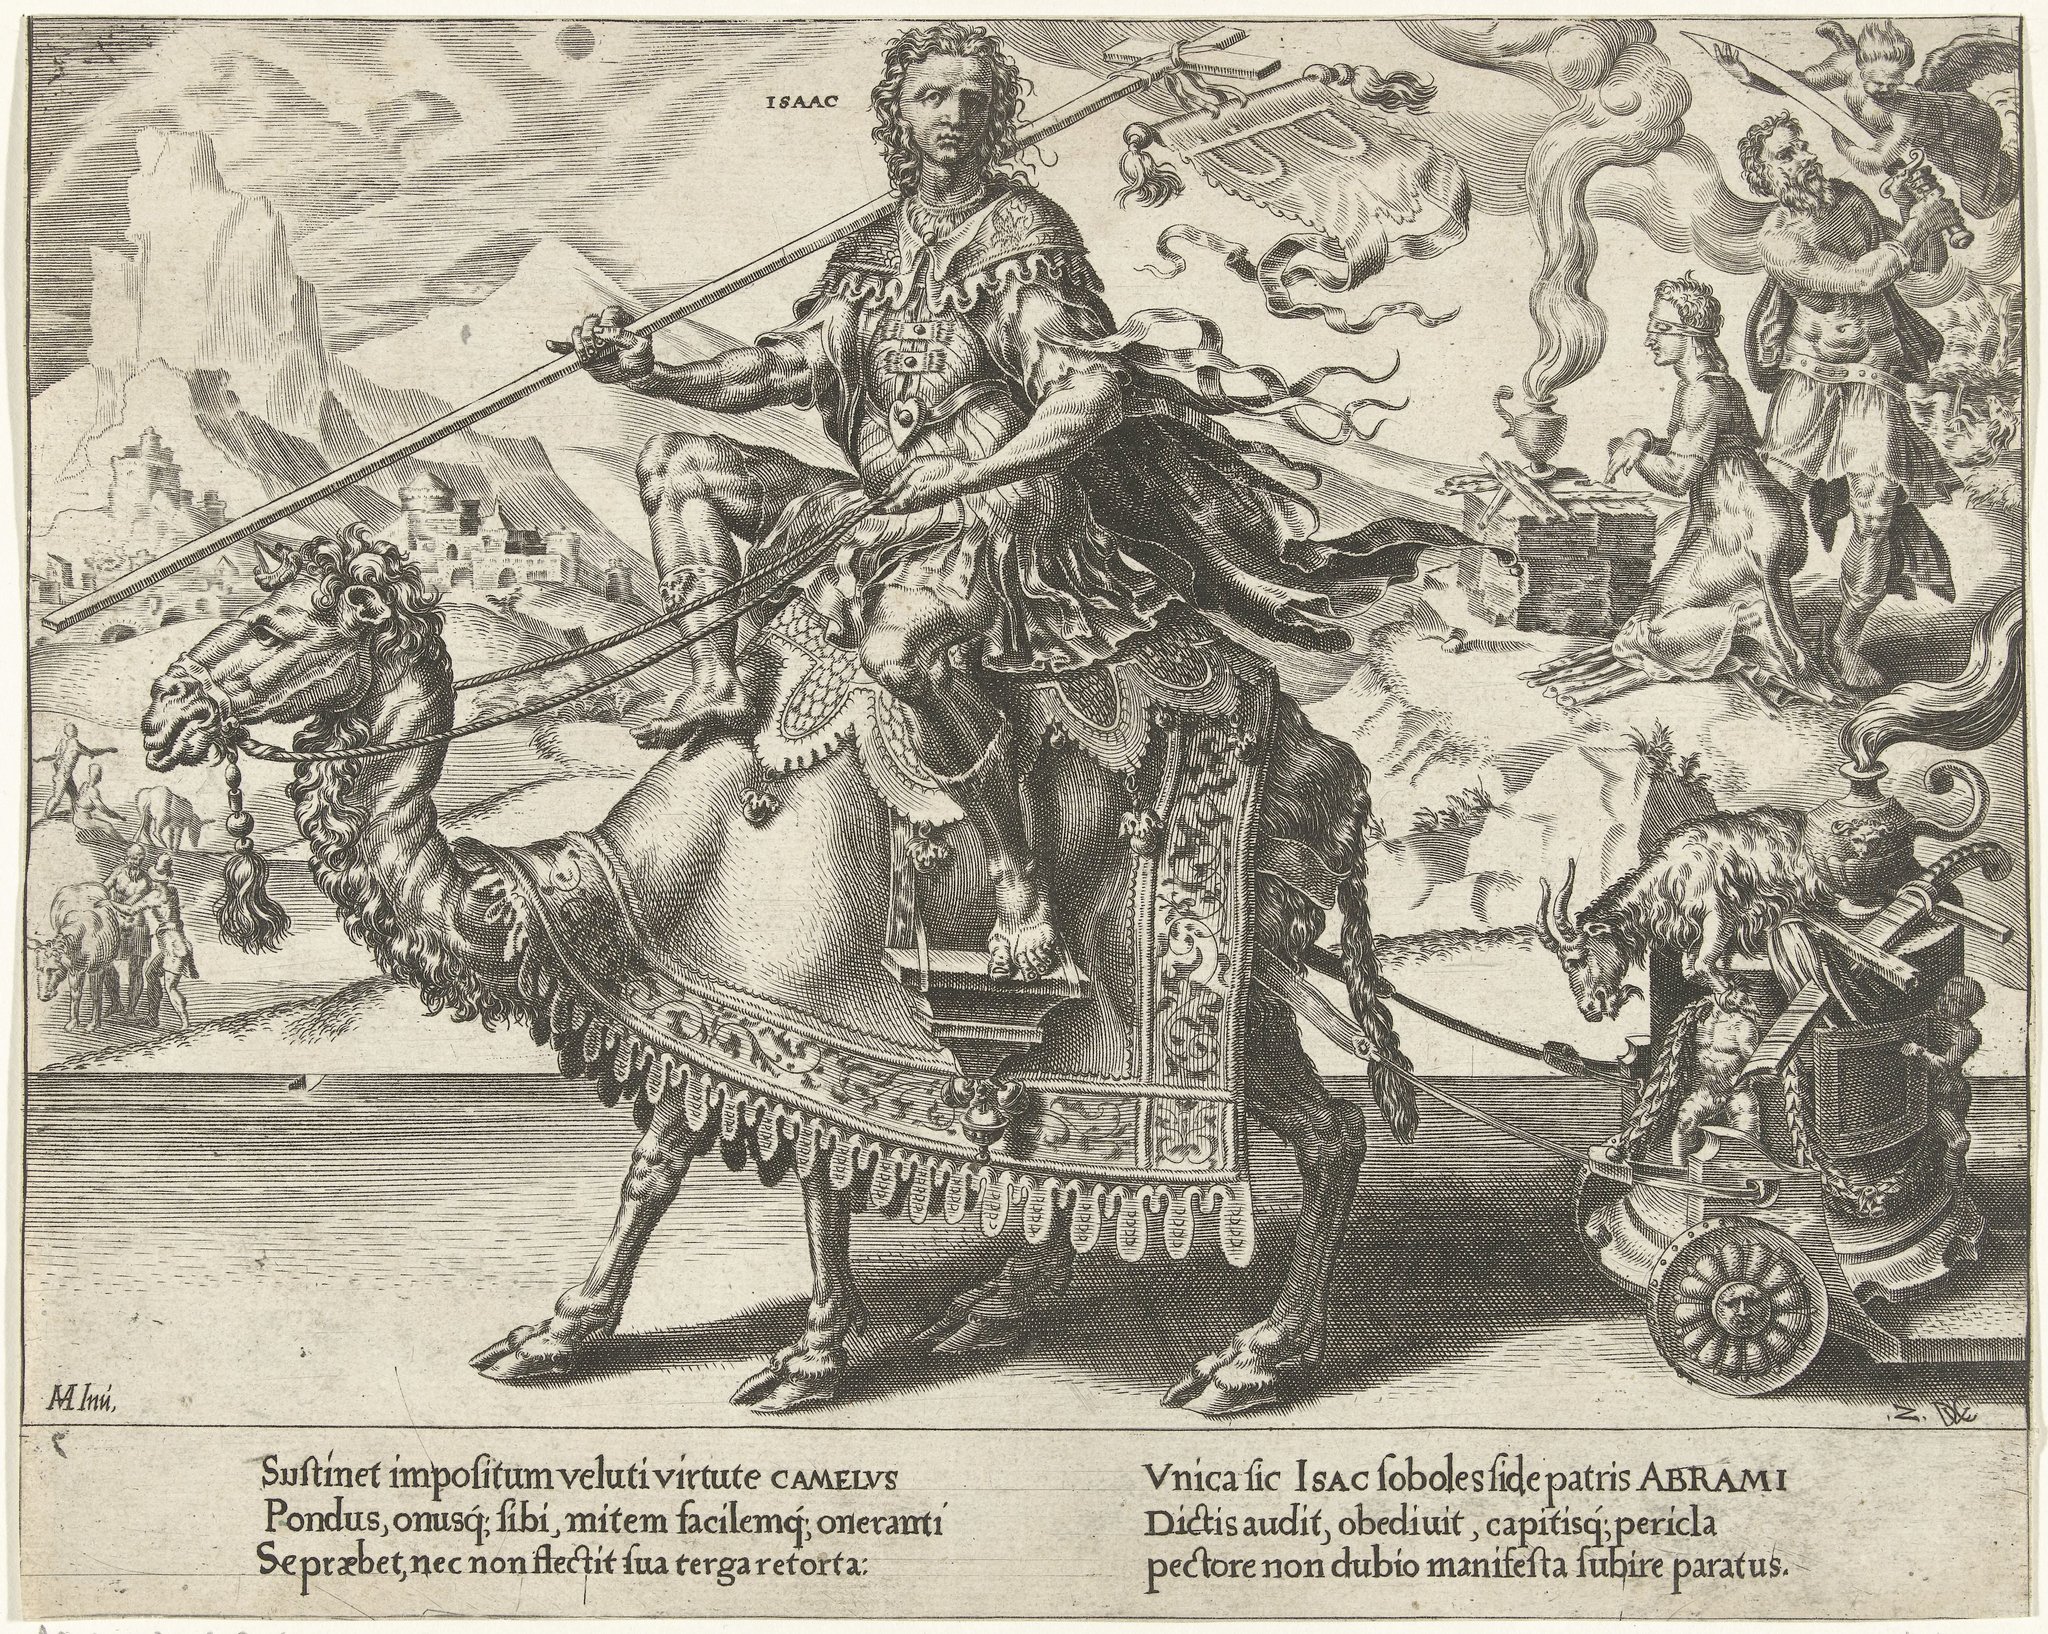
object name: print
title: Triomf van de lijdzaamheid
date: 1559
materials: paper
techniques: engraving, etching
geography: haarlem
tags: hoofed animals: dromedary, the sacrifice of isaac (genesis 22), triumphs (allegorical and symbolic), male persons from the old testament (with name) (not in biblical context)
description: Op de voorgrond Isaak, rijdend op een dromedaris. In zijn rechterhand een kruis met een vaandel. Op het vaandel twee boeien als teken van zijn vrijwillige lijdzaamheid. Hij trekt een kar met attributen van zijn lijdzaamheid: de ram die in zijn plaats werd geofferd, het zwaard van Abraham en het offervuur. Op de achtergrond rechts het offer van Isaak. De prent heeft een Latijns onderschrift van zes regels en maakt deel uit van een achtdelige serie over de triomf van de Lijdzaamheid.